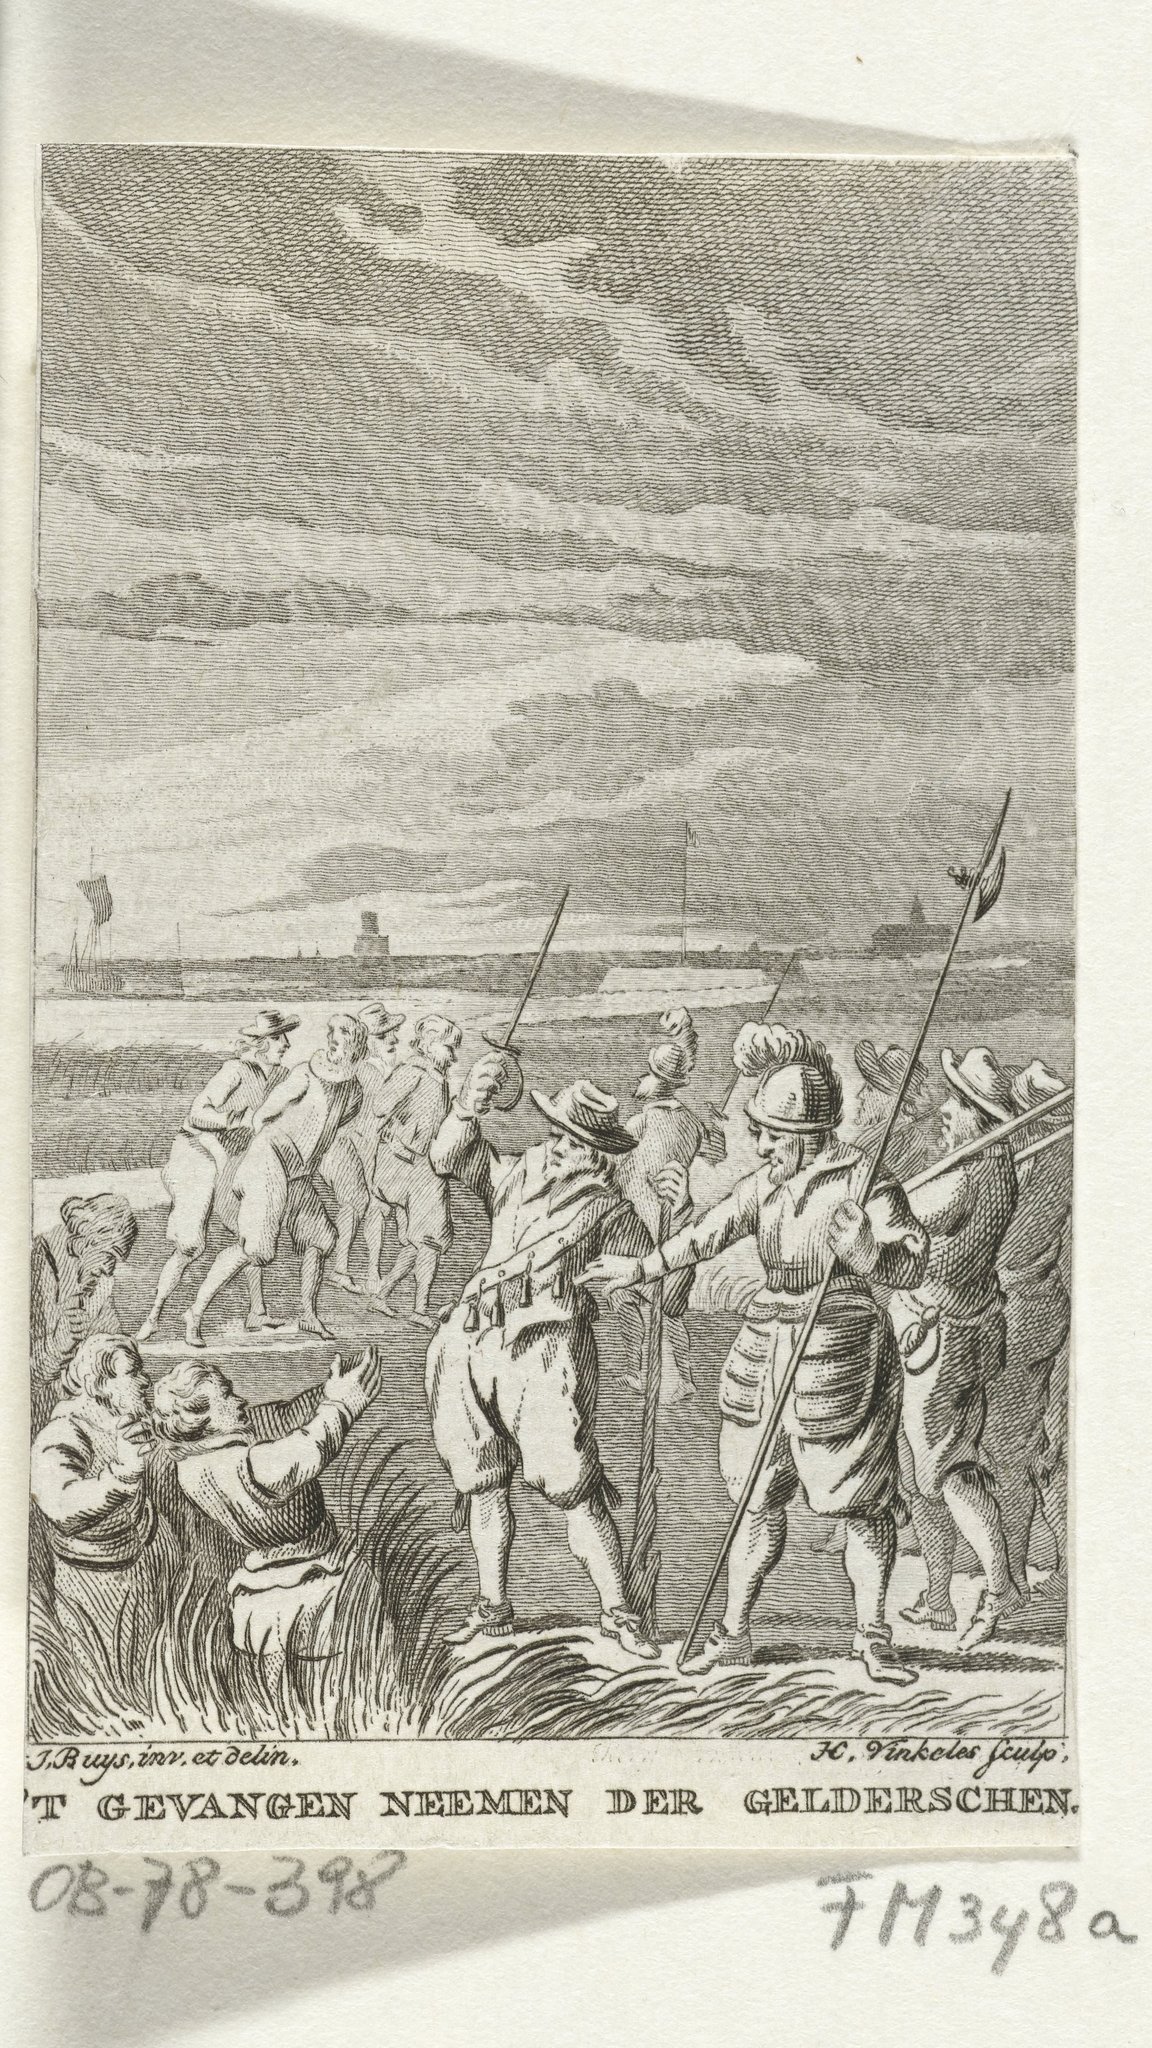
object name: print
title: Gevangenneming van Gelderse soldaten, 1507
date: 1780-1795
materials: paper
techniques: etching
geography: netherlands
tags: prisoner of war (after the battle), netherlands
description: Illustratie voor: J. Fokke, Geschiedenissen der Vereenigde Nederlanden voor de vaderlandsche jeugd, Johannes Allart, Amsterdam 1783-1795, 25 delen, dl. III, pl. III (?). Staat met de letter.